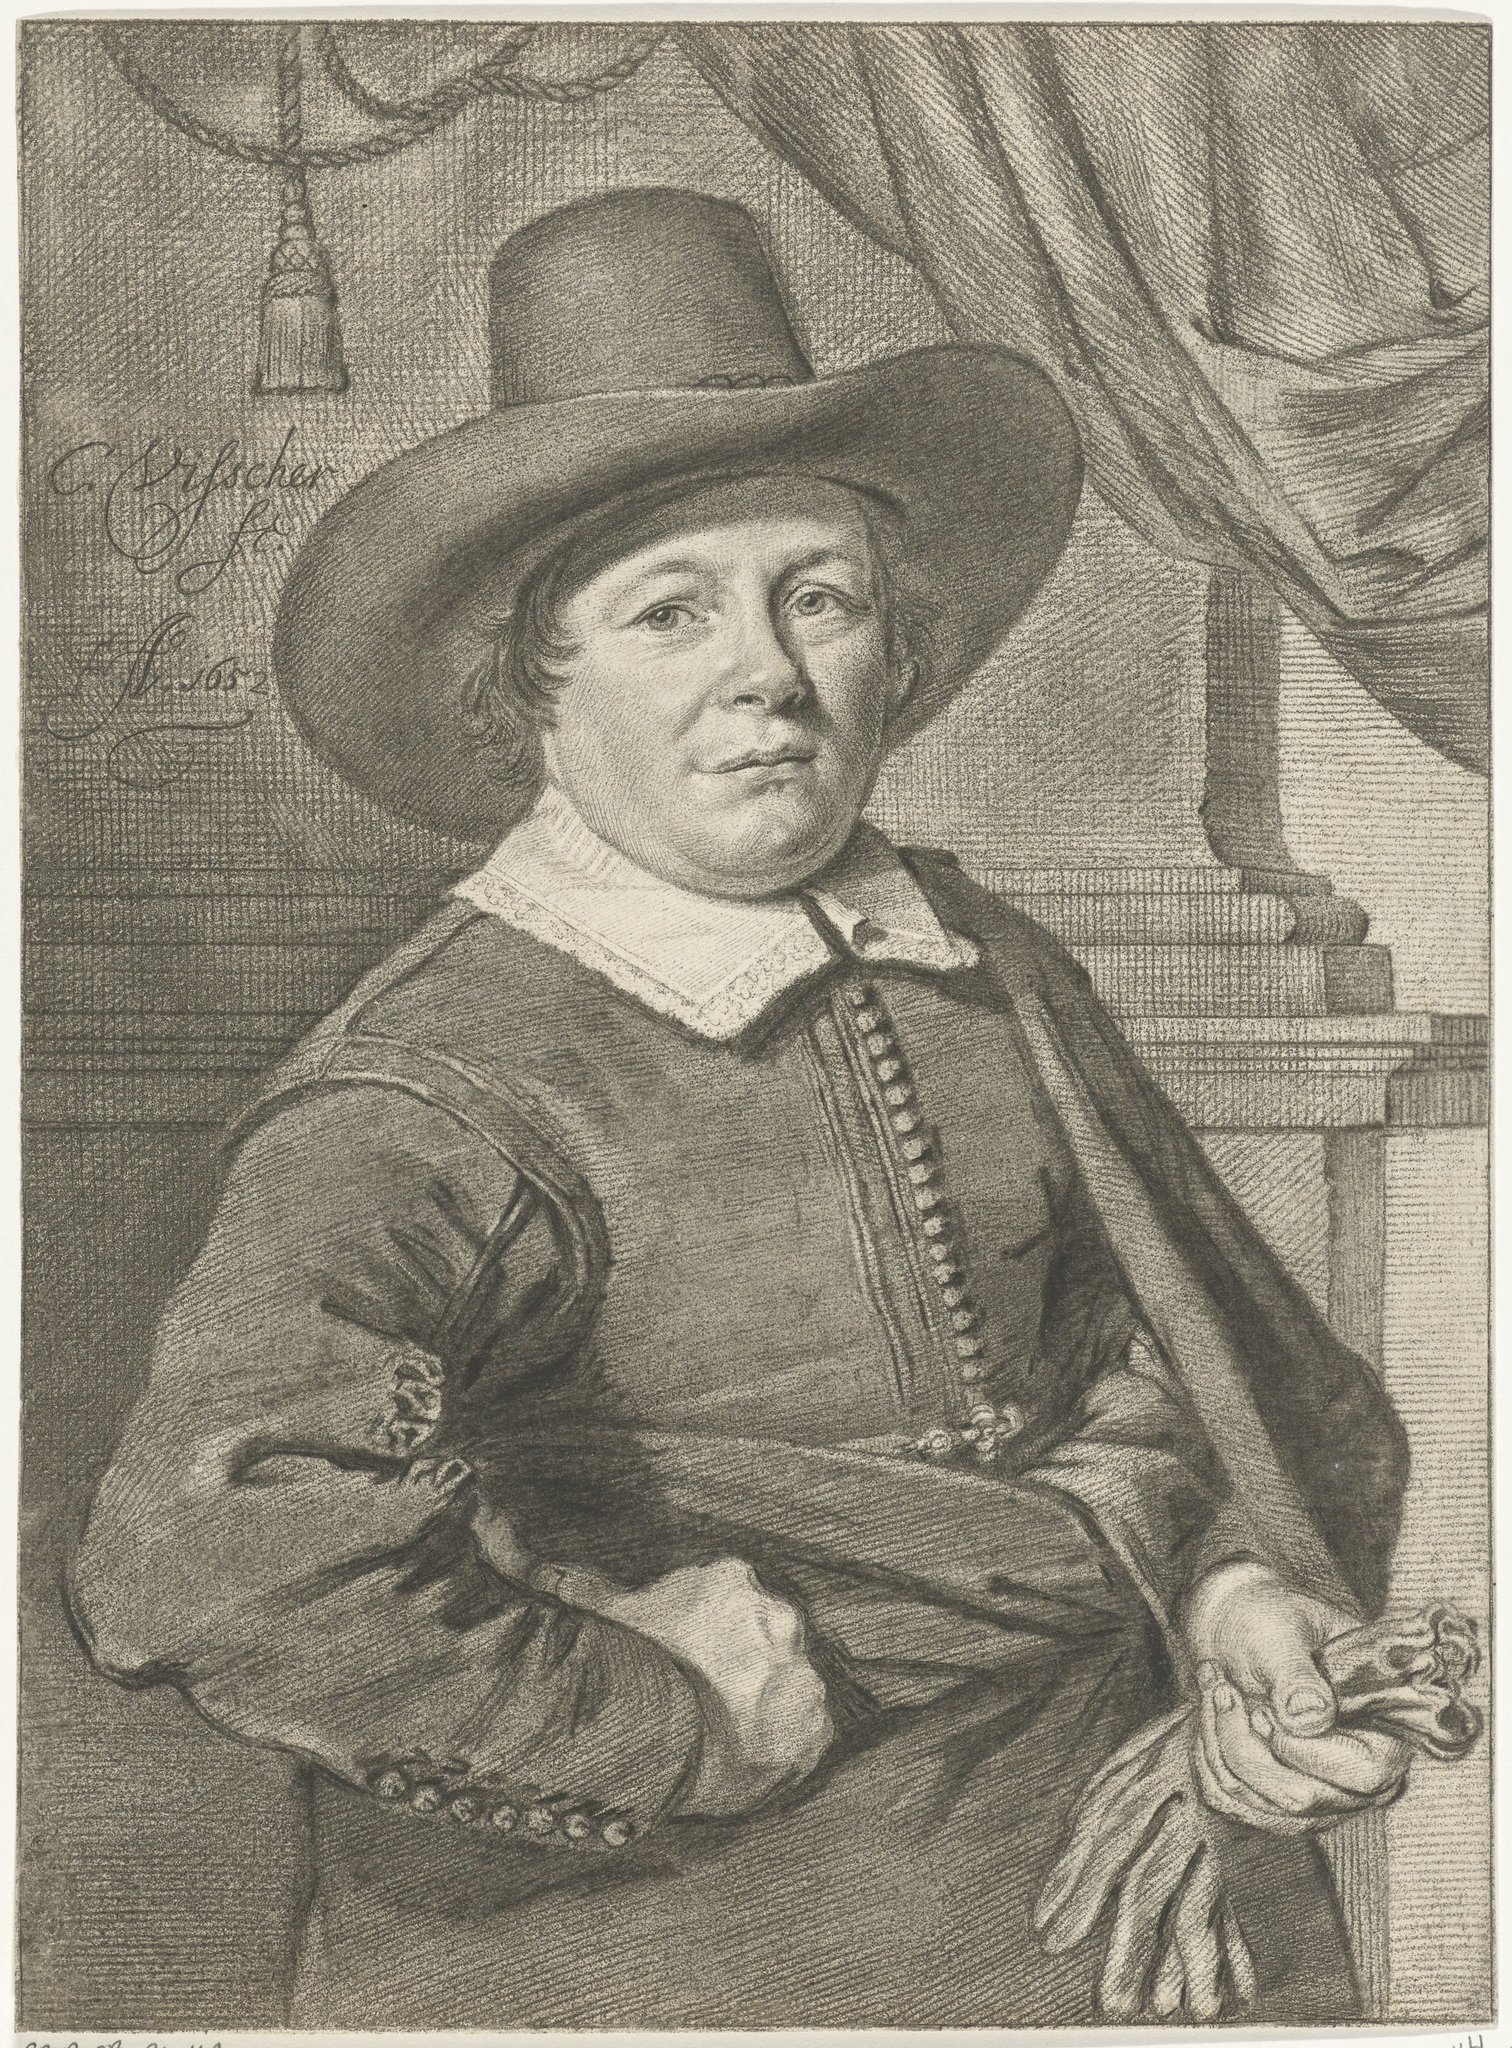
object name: print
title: Portret van Jacob de Groot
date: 1769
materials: paper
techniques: printmaking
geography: haarlem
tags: gloves, mittens, etc., historical persons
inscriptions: collector's mark: Lugt 240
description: Portret van Jacob de Groot, alias Jaap Stront, waard in Hof van Holland in de Warmoesstraat, Amsterdam. Op de achtergrond een gordijn en lijstwerk.